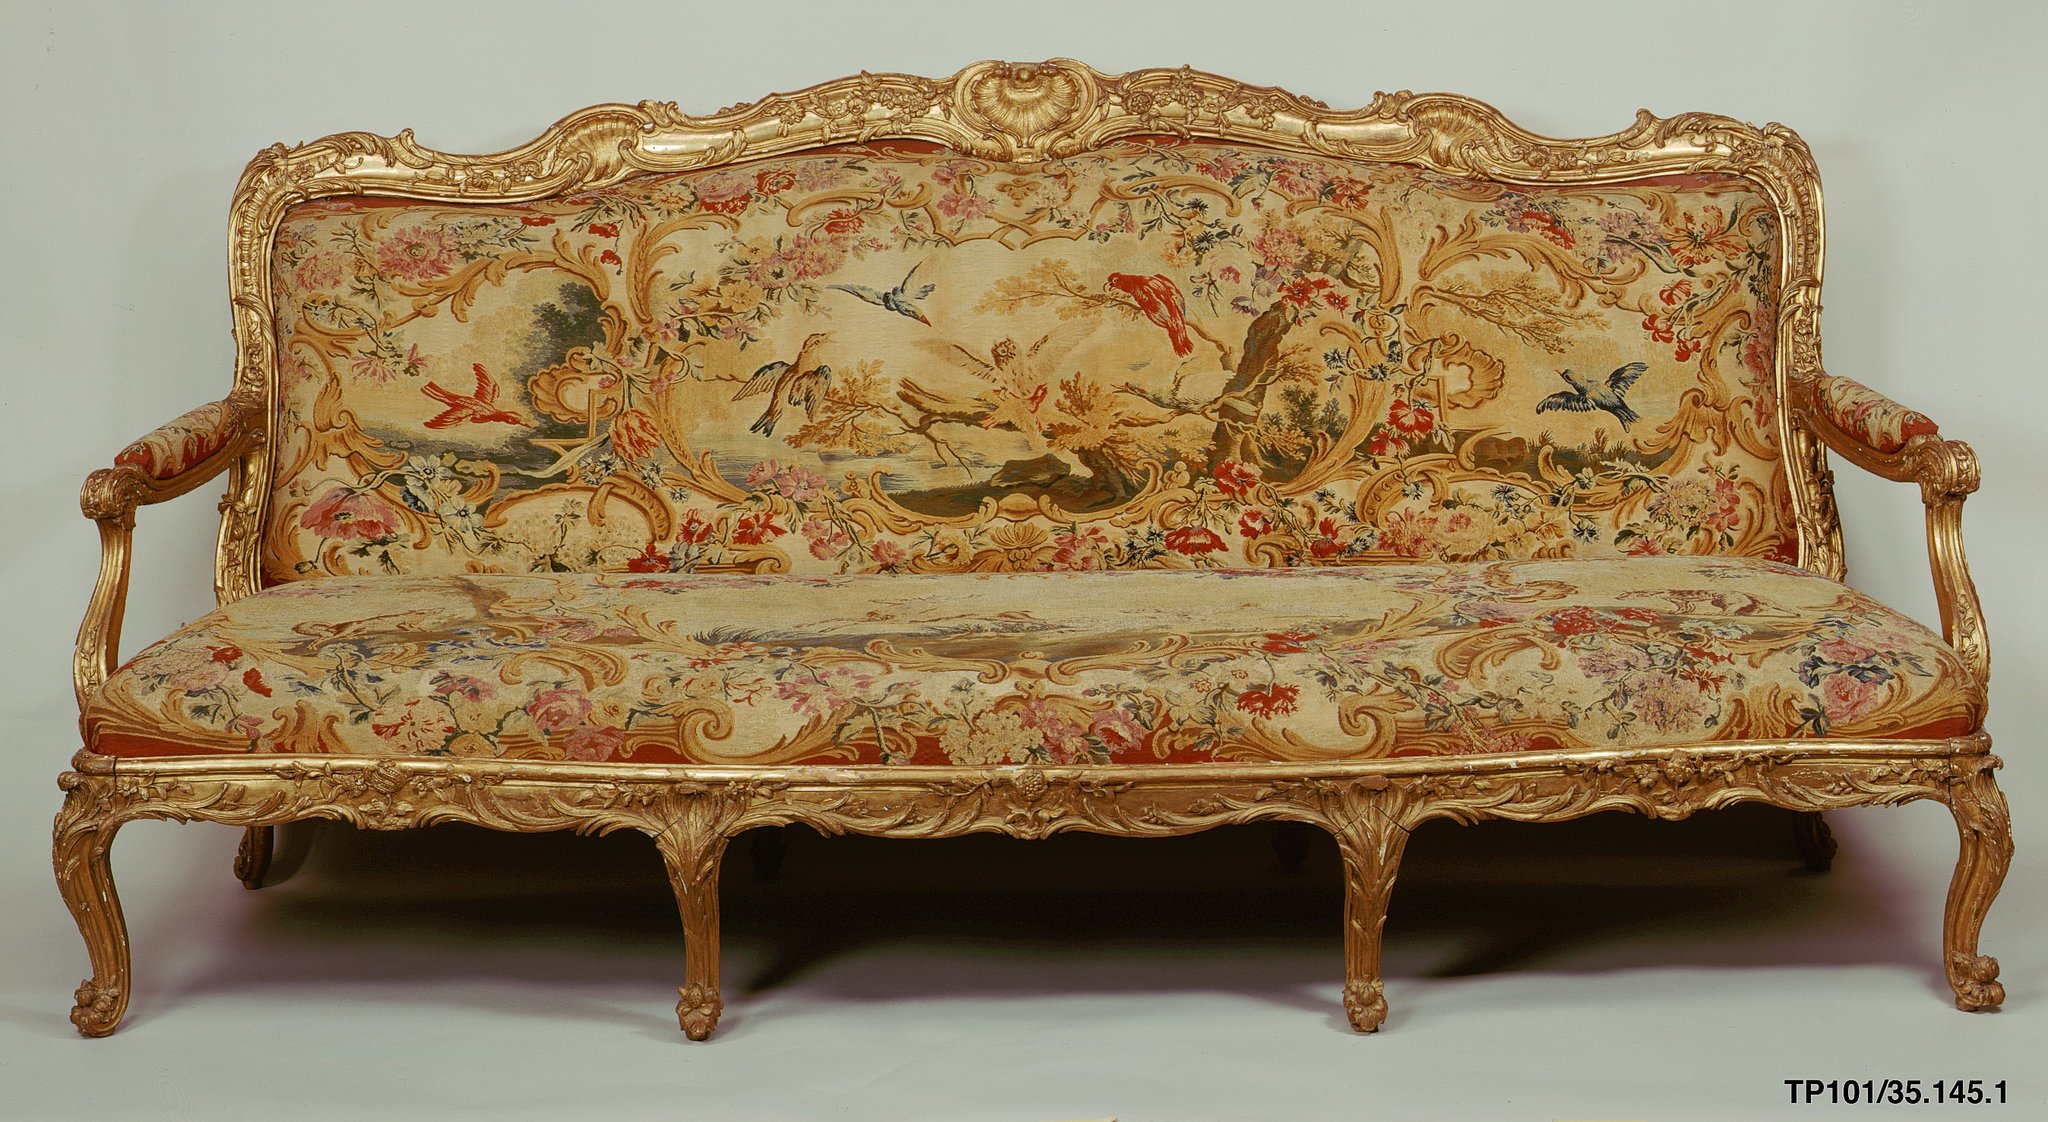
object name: settee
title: Settee (canapé) (part of a set)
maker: nicolas-quinibert foliot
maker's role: maker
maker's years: 1706-1776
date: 1754-1756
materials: wood, silk, wool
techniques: carving, gilding, tapestry